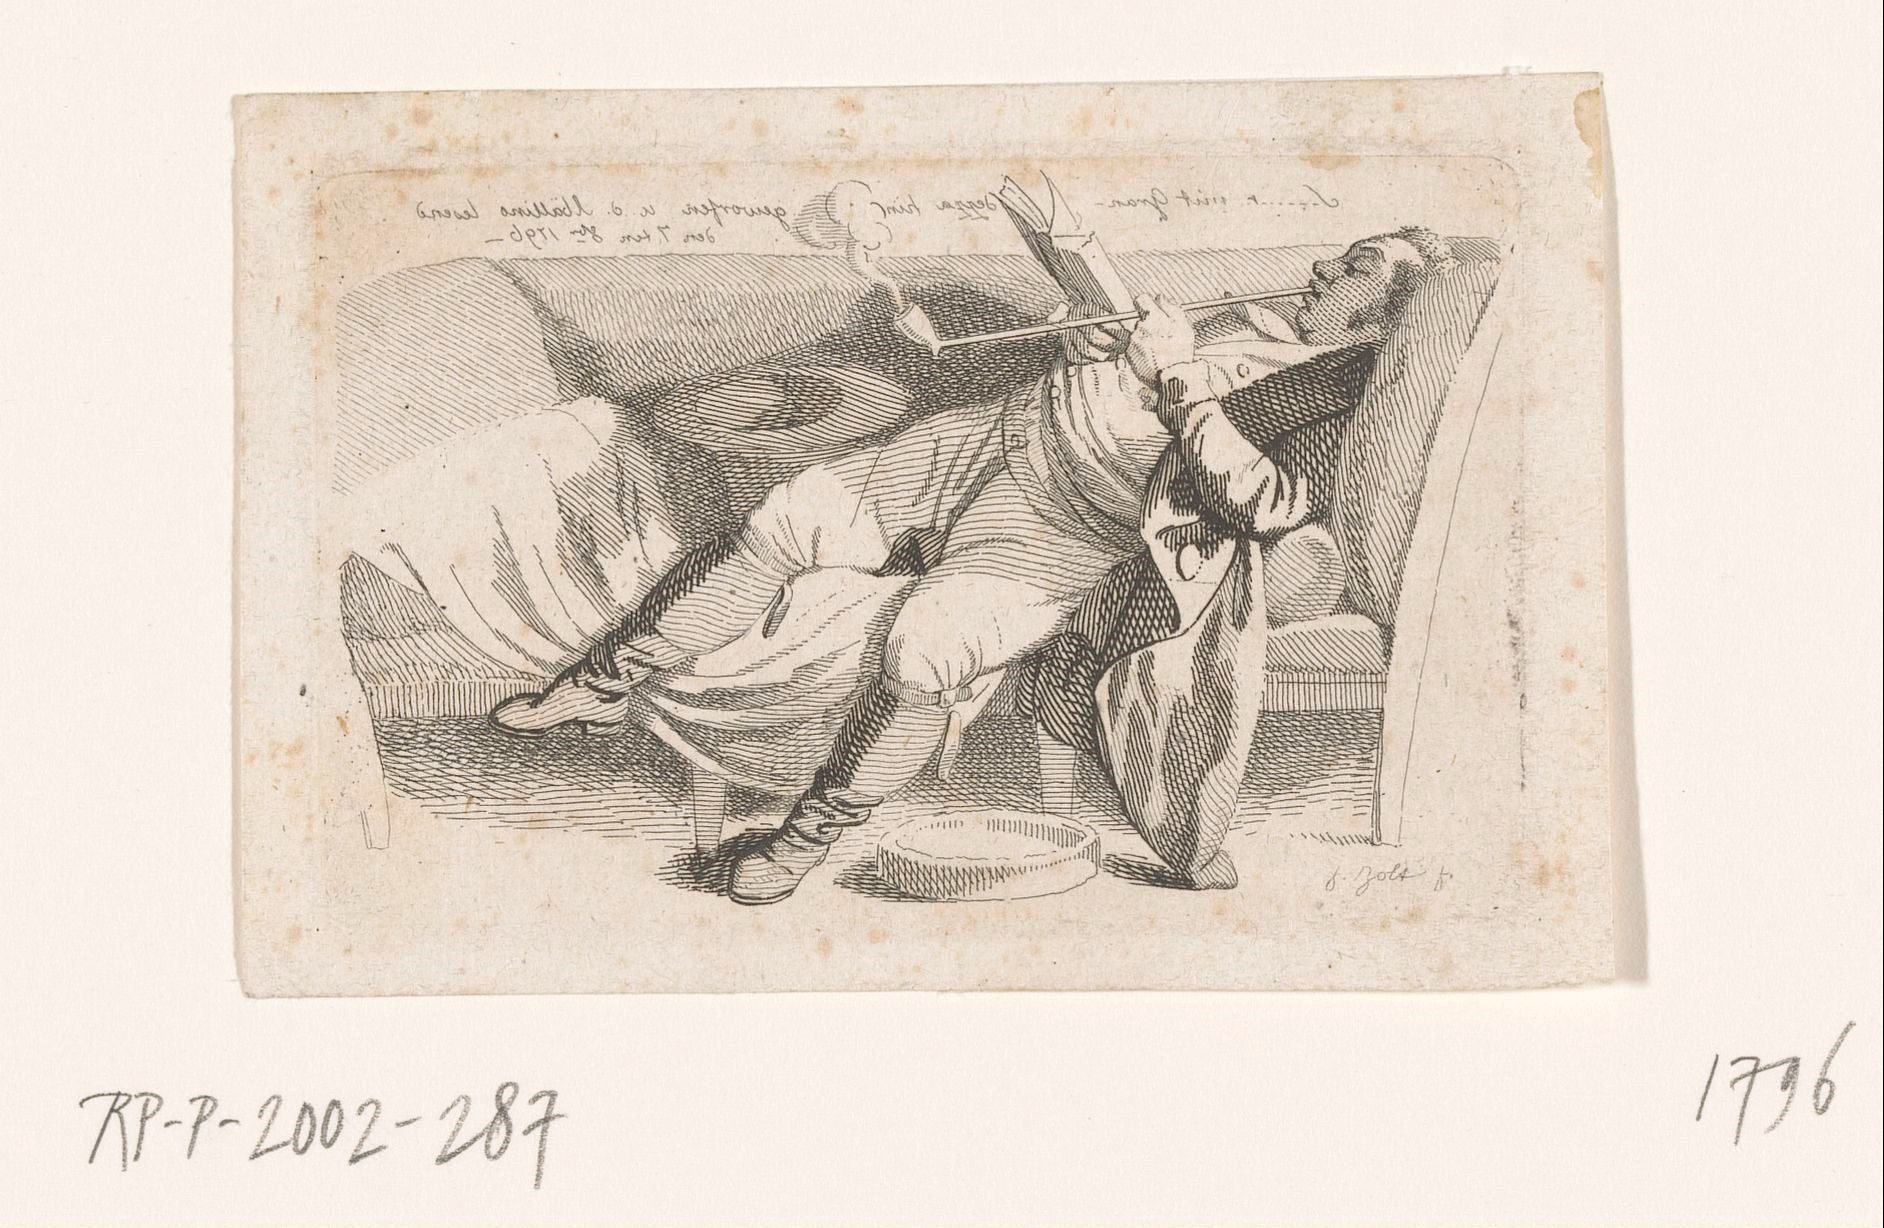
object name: print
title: Lezende man op een sofa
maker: johann friedrich bolt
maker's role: print maker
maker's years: 1769-1836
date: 1796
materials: paper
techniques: etching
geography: berlin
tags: reading, pipe ~ tobacco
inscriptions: collector's mark: Lugt 2760, collector's mark: Lugt 2228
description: Een pijprokende man ligt te lezen op een sofa. Boven hem in spiegelschrift de tekst: 'S...r mit Grandezza hingeworfen u. d. Abällino lesend, den 7ten Sbr. 1796'.